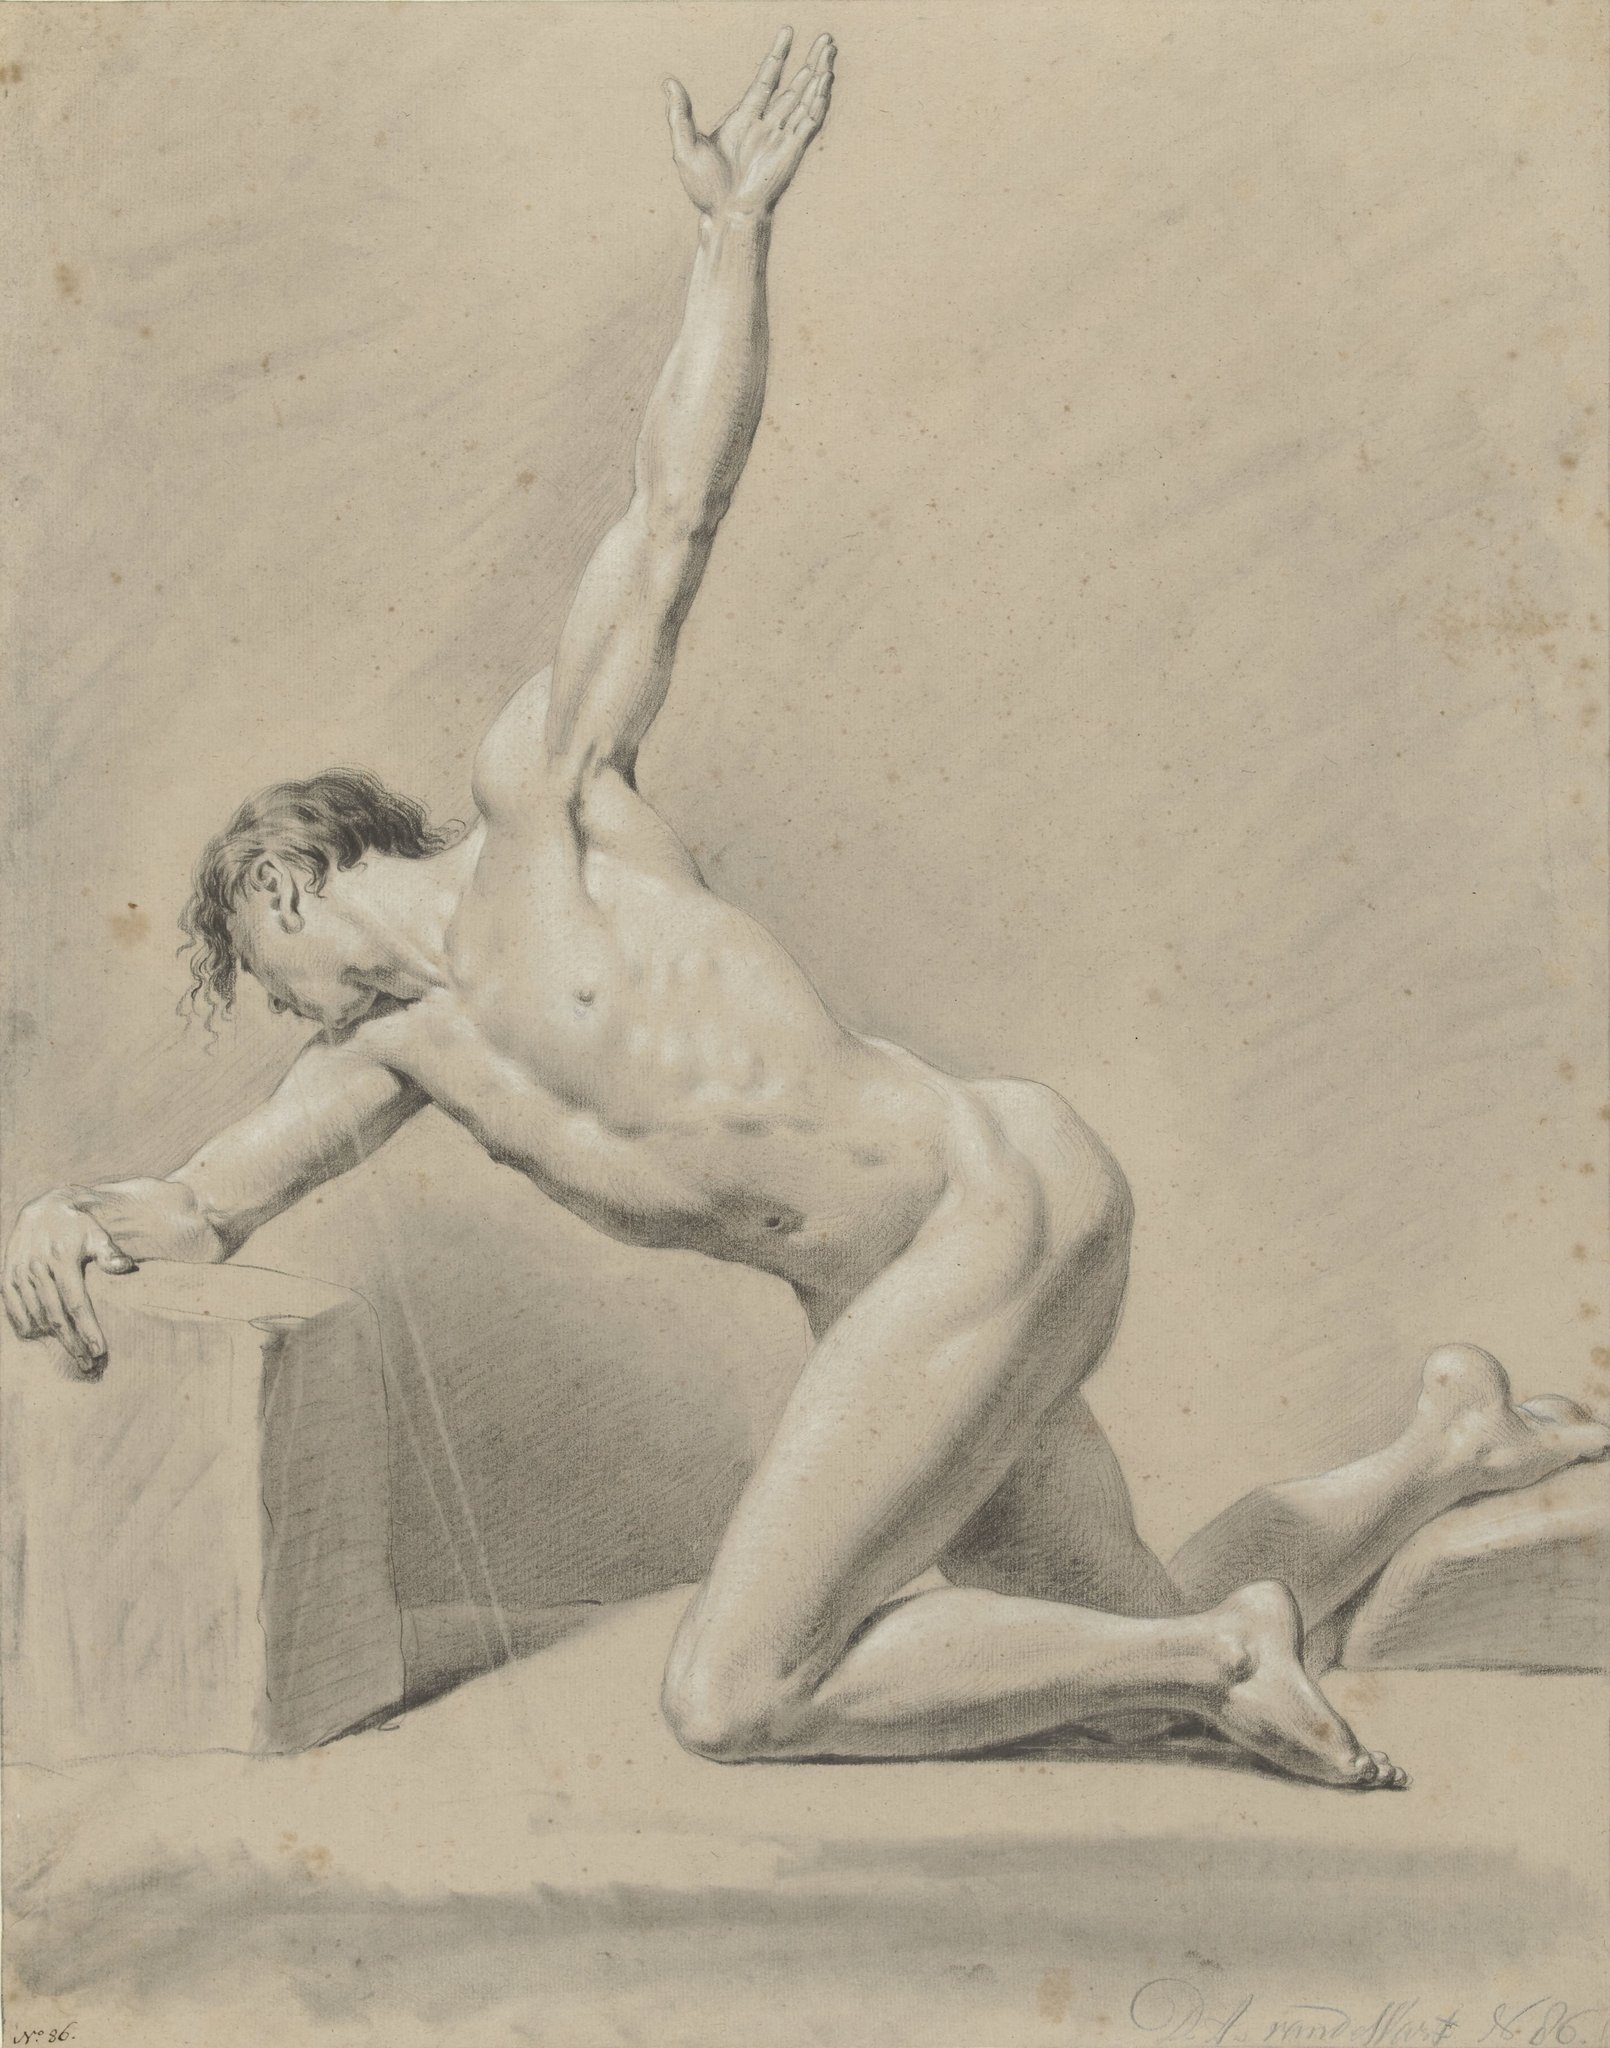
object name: drawing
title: Mannelijk naakt, genield op de linkerknie, naar links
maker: derk anthony van de wart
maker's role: draughtsman, painter, print maker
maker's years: 1767-1824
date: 1780-1824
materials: chalk, paper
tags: kneeling figure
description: Mannelijk naakt, genield op de linkerknie, naar links, de linkerarm hoog geheven. Linksonder: no. 86 Rechtsonder: D. A. van de Wart N 86.